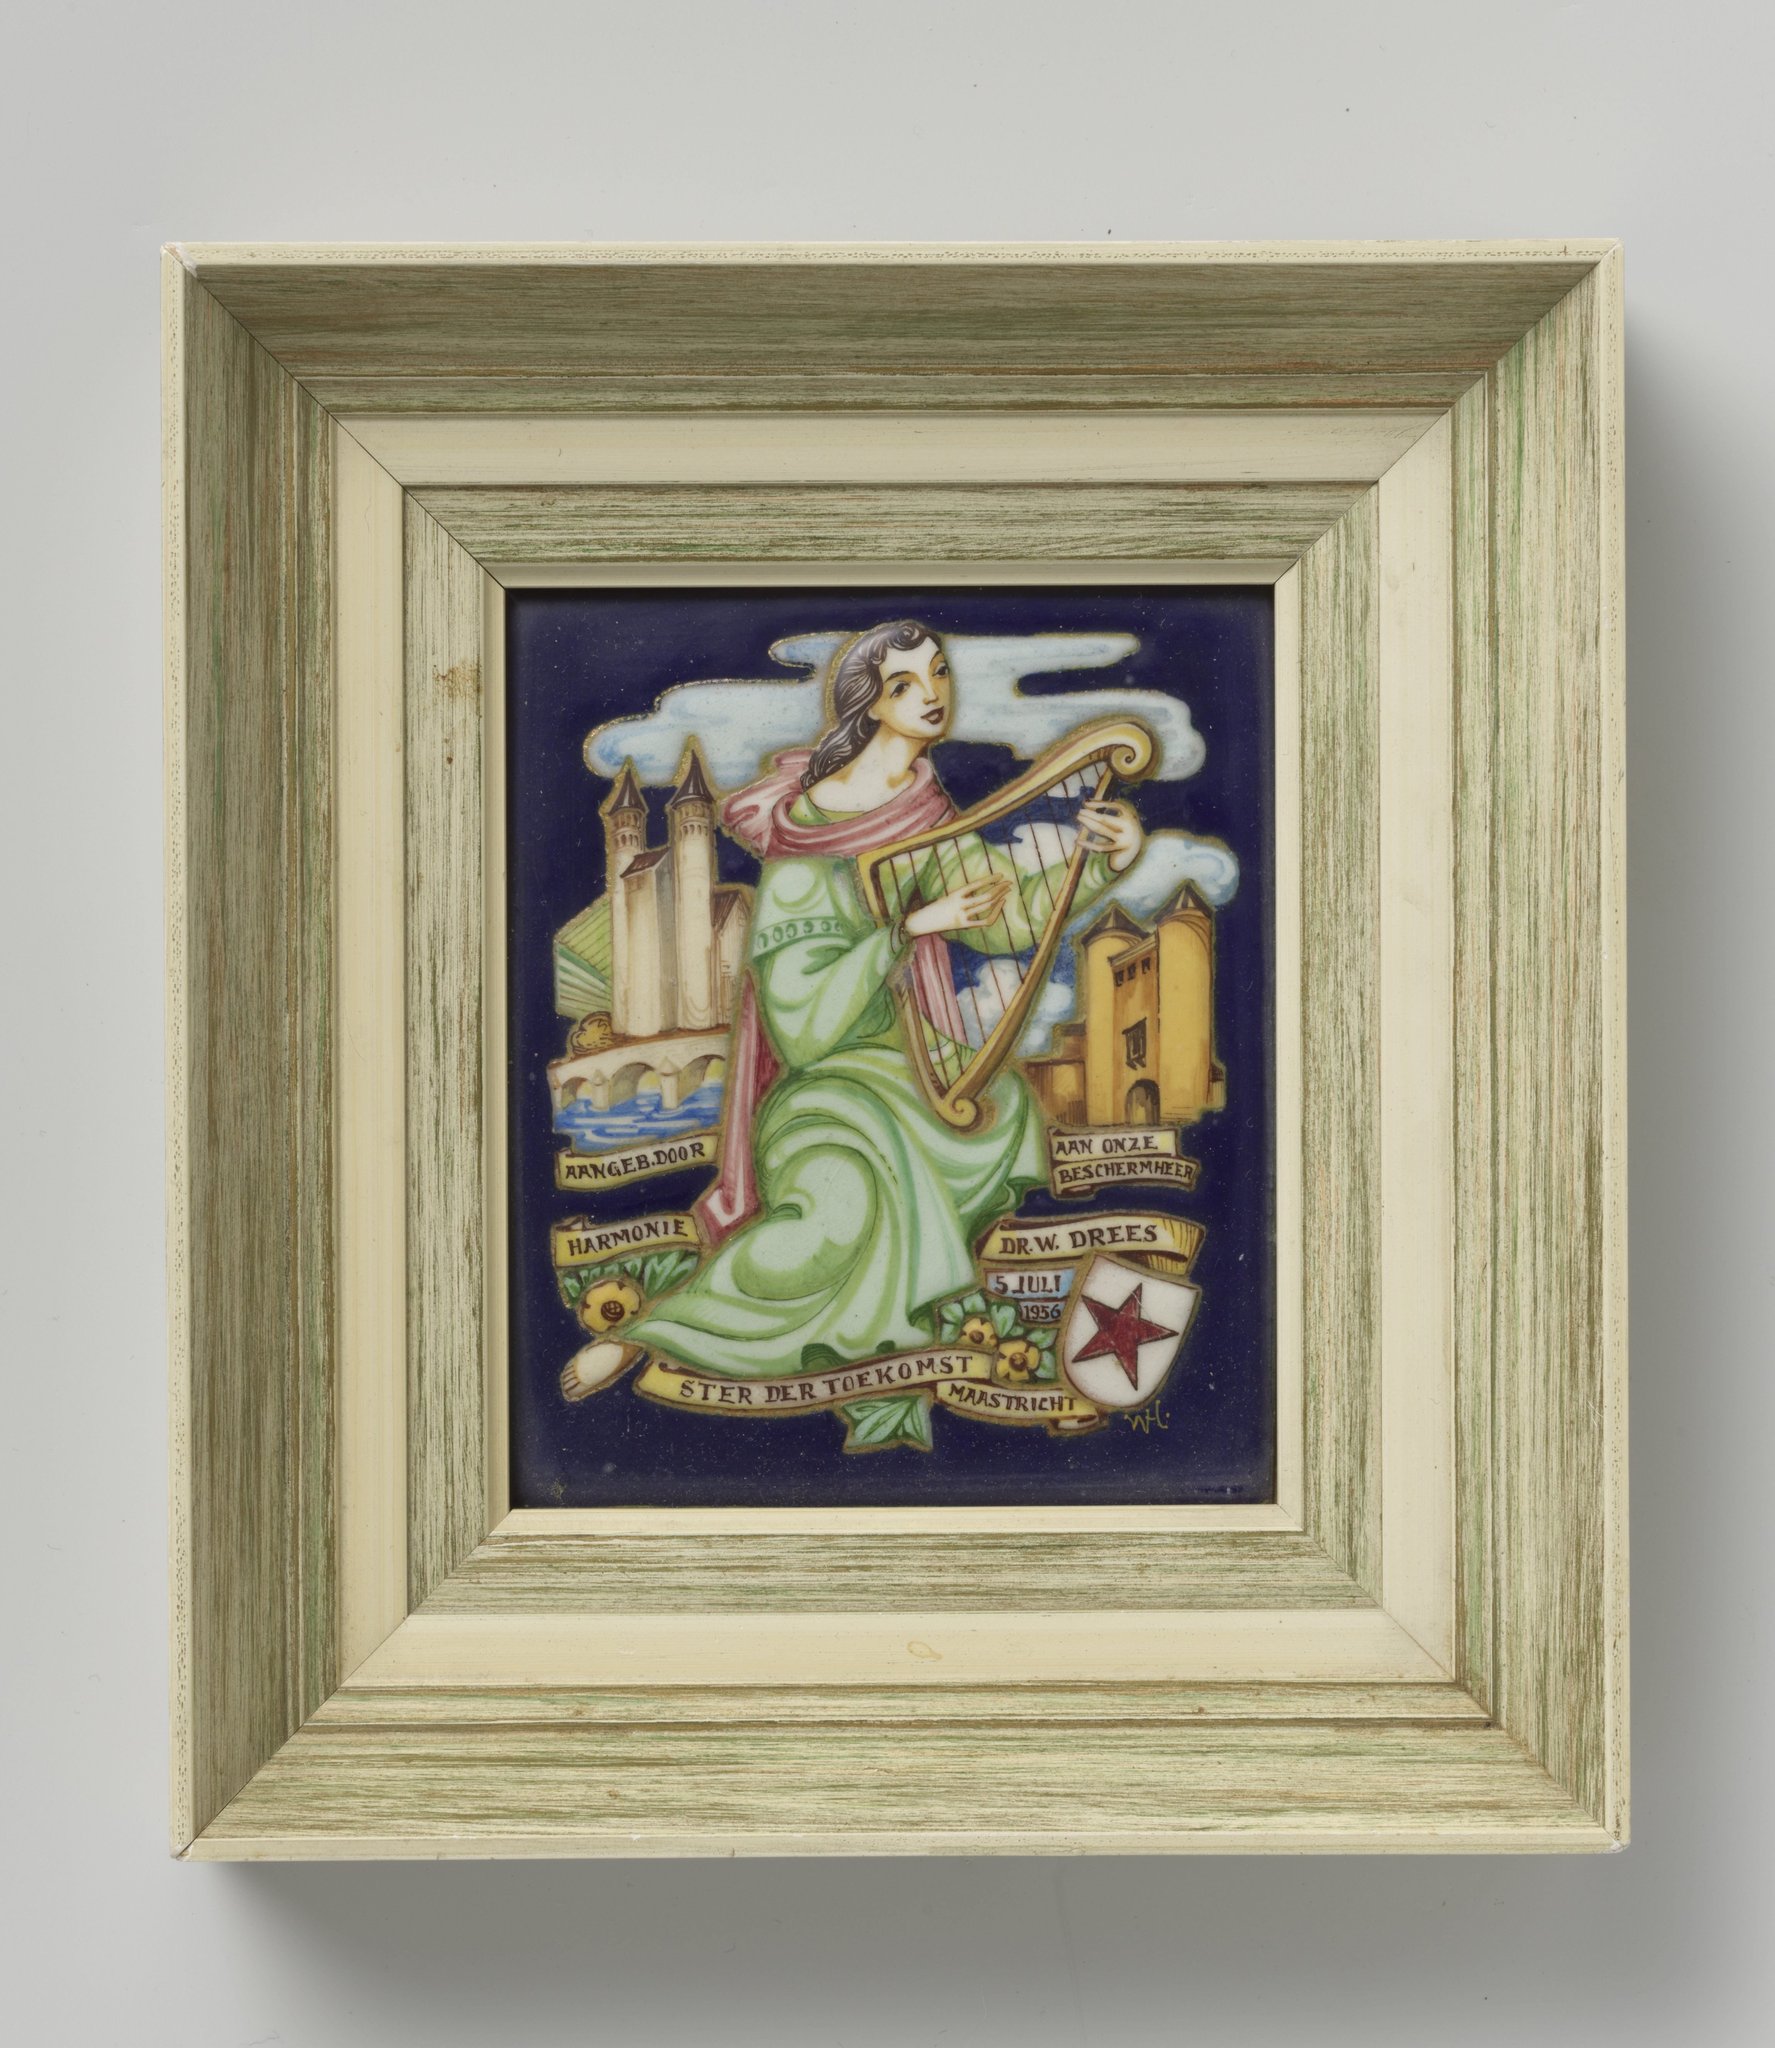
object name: tile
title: Geëmailleerde tegel aangeboden aan beschermheer W. Drees door harmonie 'ster der toekomst' te Maastricht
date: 1956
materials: metal, plastic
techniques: enameling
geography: maastricht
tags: amsterdam, willem drees, harp, maastricht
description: Geëmailleerde tegel in plastic lijst waarop een voorstelling van een harp spelende Madonna. Rond haar groene rok loopt de tekst 'aangeb. door harmonie ster der toekomst maastricht' en 'aan onze beschermheer Dr. W. Drees, 5 juli 1956'. Gesigneerd WH.